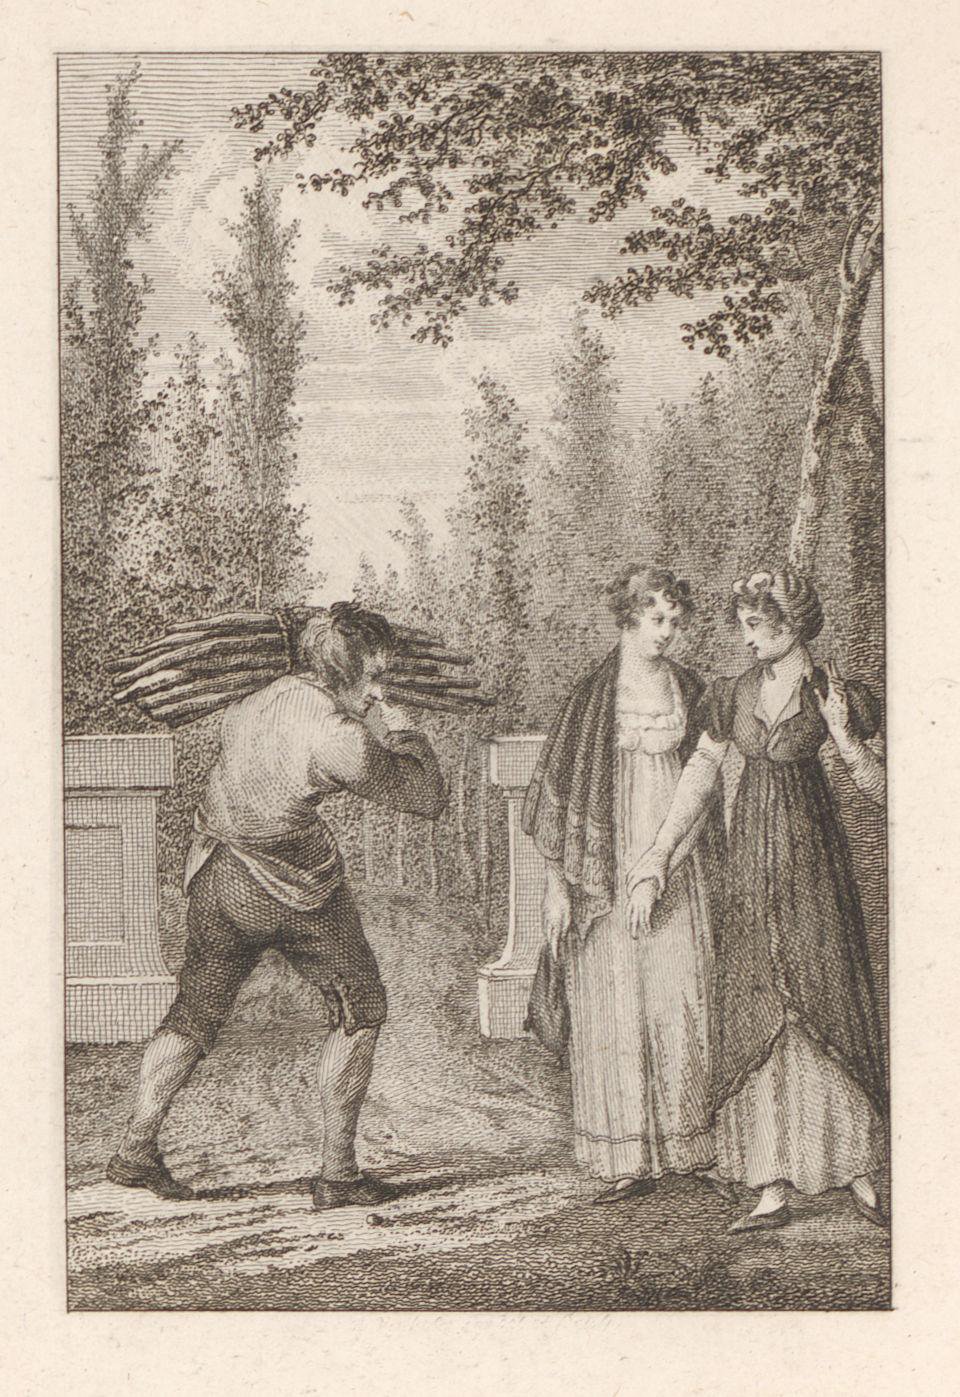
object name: album leaf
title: Twee jongen vrouwen en een man met een takkenbos op zijn rug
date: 1809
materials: paper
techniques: engraving, etching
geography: haarlem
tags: adolescent, young woman, maiden, forest, wood, carrying something on the head or on the shoulders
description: In een boomrijke omgeving kijken twee jonge vrouwen hoe een man een bundel takken op zijn schouder draagt. De prent maakt deel uit van een album.